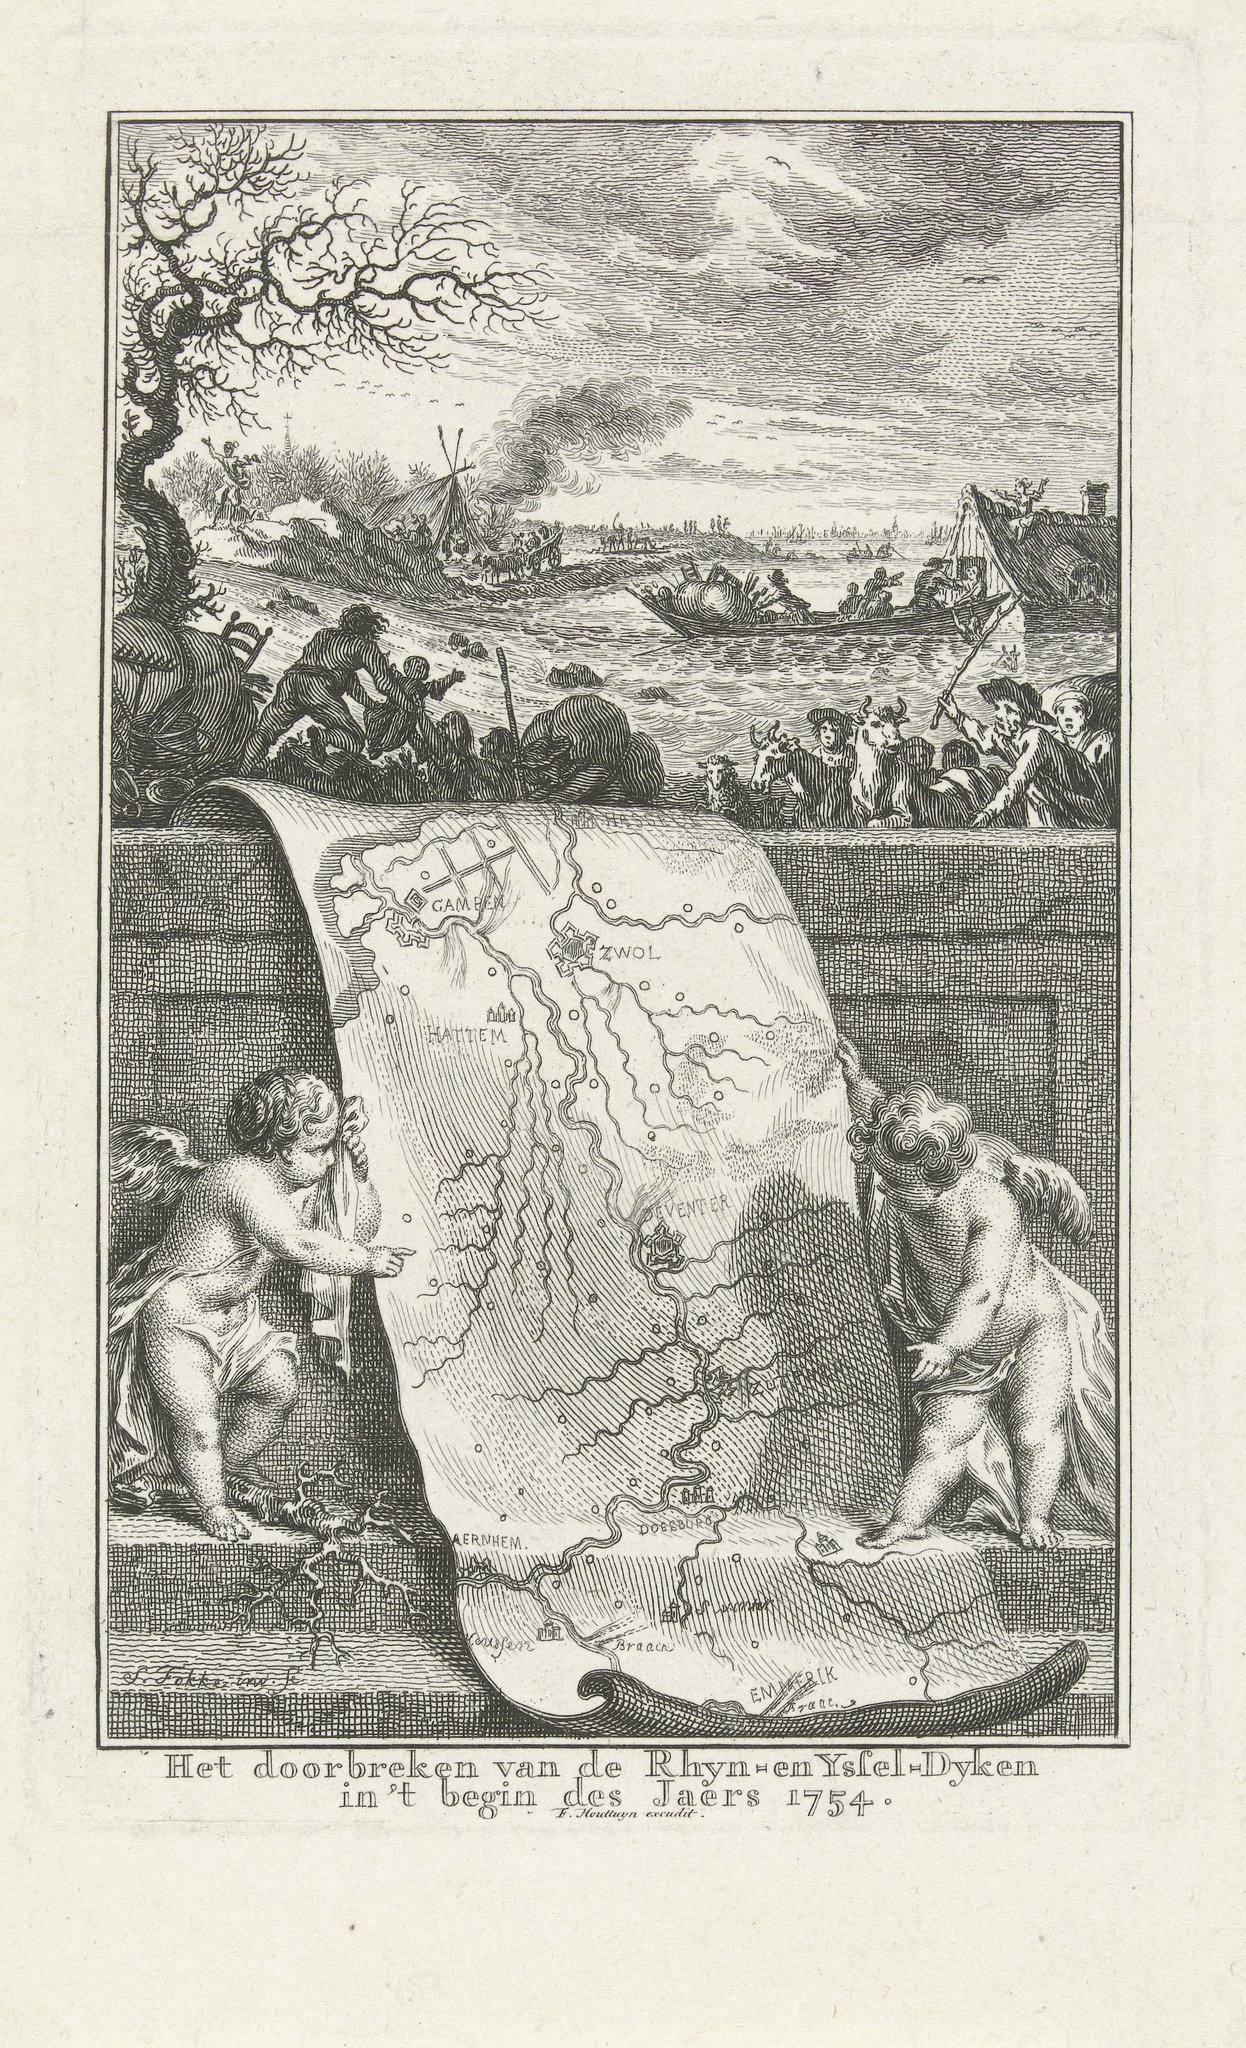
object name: print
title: Doorbraak van de Rijn- en IJsseldijken, 1754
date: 1754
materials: paper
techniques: engraving, etching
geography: northern netherlands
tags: dike-break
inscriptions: collector's mark: Lugt 2228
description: Watersnood na het doorbreken van de rivierdijken langs de Rijn en de IJssel, januari 1754. Onderaan twee putti met een kaart van het rivierengebied tussen Kampen en Emmerich, bovenaan ontvluchten bewoners het overstroomde land met huisraad en vee.